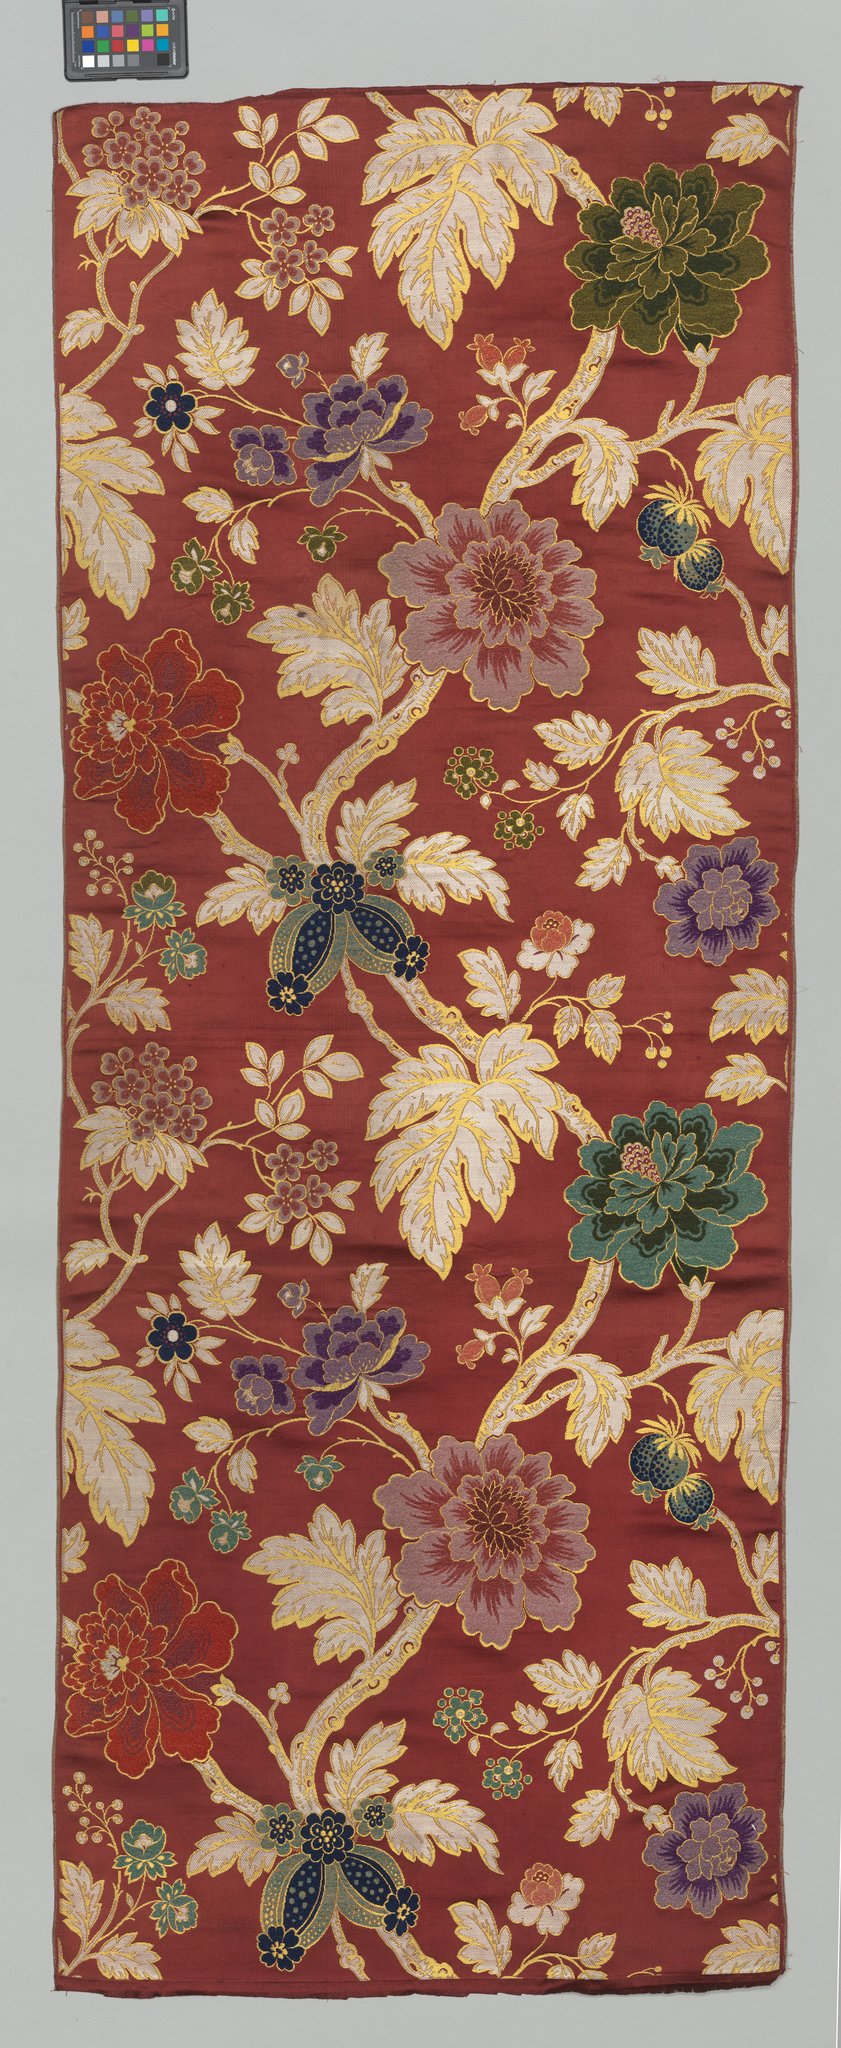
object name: piece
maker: bouvard, burel et cie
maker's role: manufactory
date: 1860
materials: silk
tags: flowers